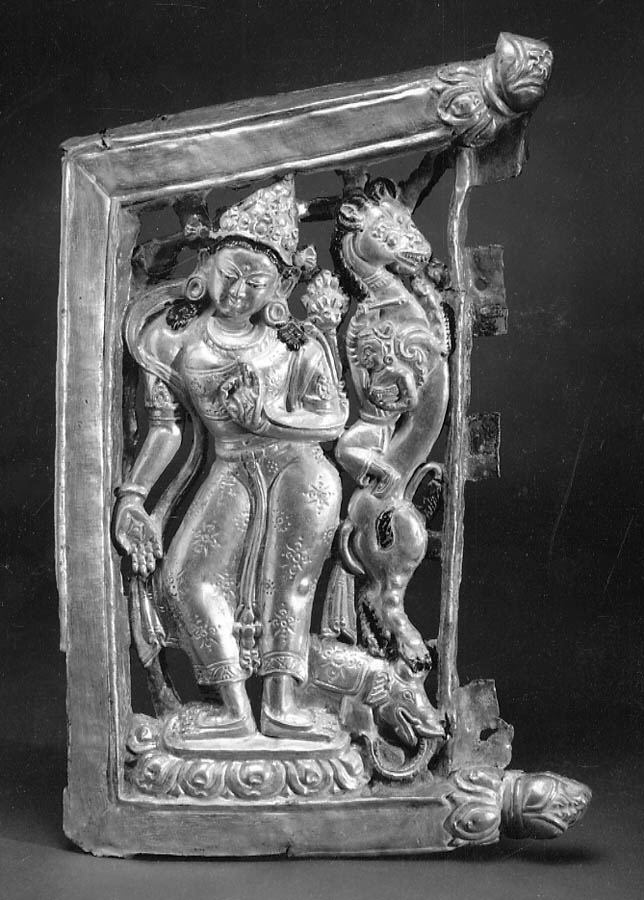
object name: halo element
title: Side Element from a Halo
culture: tibetan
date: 1301-1500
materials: copper alloy, gilt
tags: mythical creatures,elephants,bodhisattvas